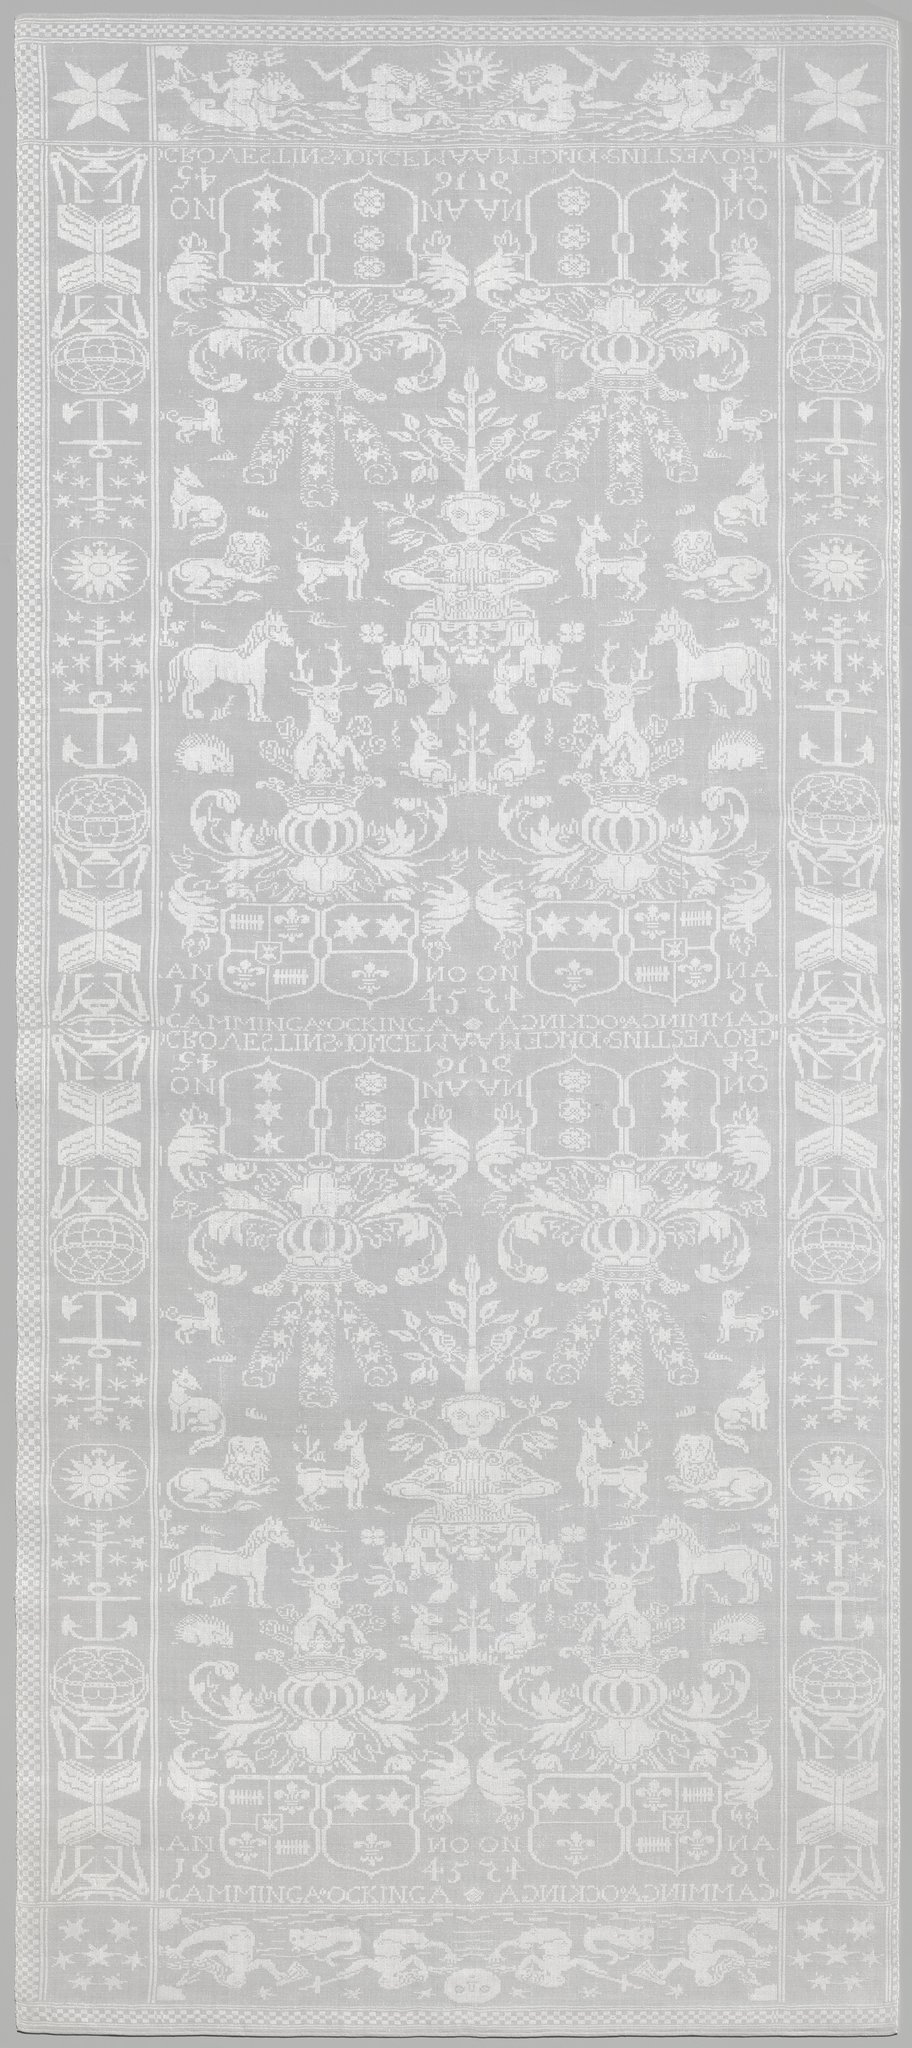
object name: handdwaal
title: Handdwaal met Orpheus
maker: Anonymous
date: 1645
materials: linen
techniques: damask, weave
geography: northern netherlands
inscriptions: name: ‘CAMMINGA.OCKINGA en GROVESTINS.IONGEMA’, date: ‘ANNO 1645’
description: Handdwaal van linnendamast met Orpheus temidden van de dieren. Middenveld: het symmetrisch patroon wordt twee maal herhaald en vertoont van onder naar boven ingeweven naam en datum 1645, wapens van Camminga-Ockinga en Grovestins-Jongema, helmen met pluimen, gezeten figuur (Orpheus) met rondom allerlei dieren. Staande randen: nautische voorstelling. Liggende randen zeemeerminnen en ...